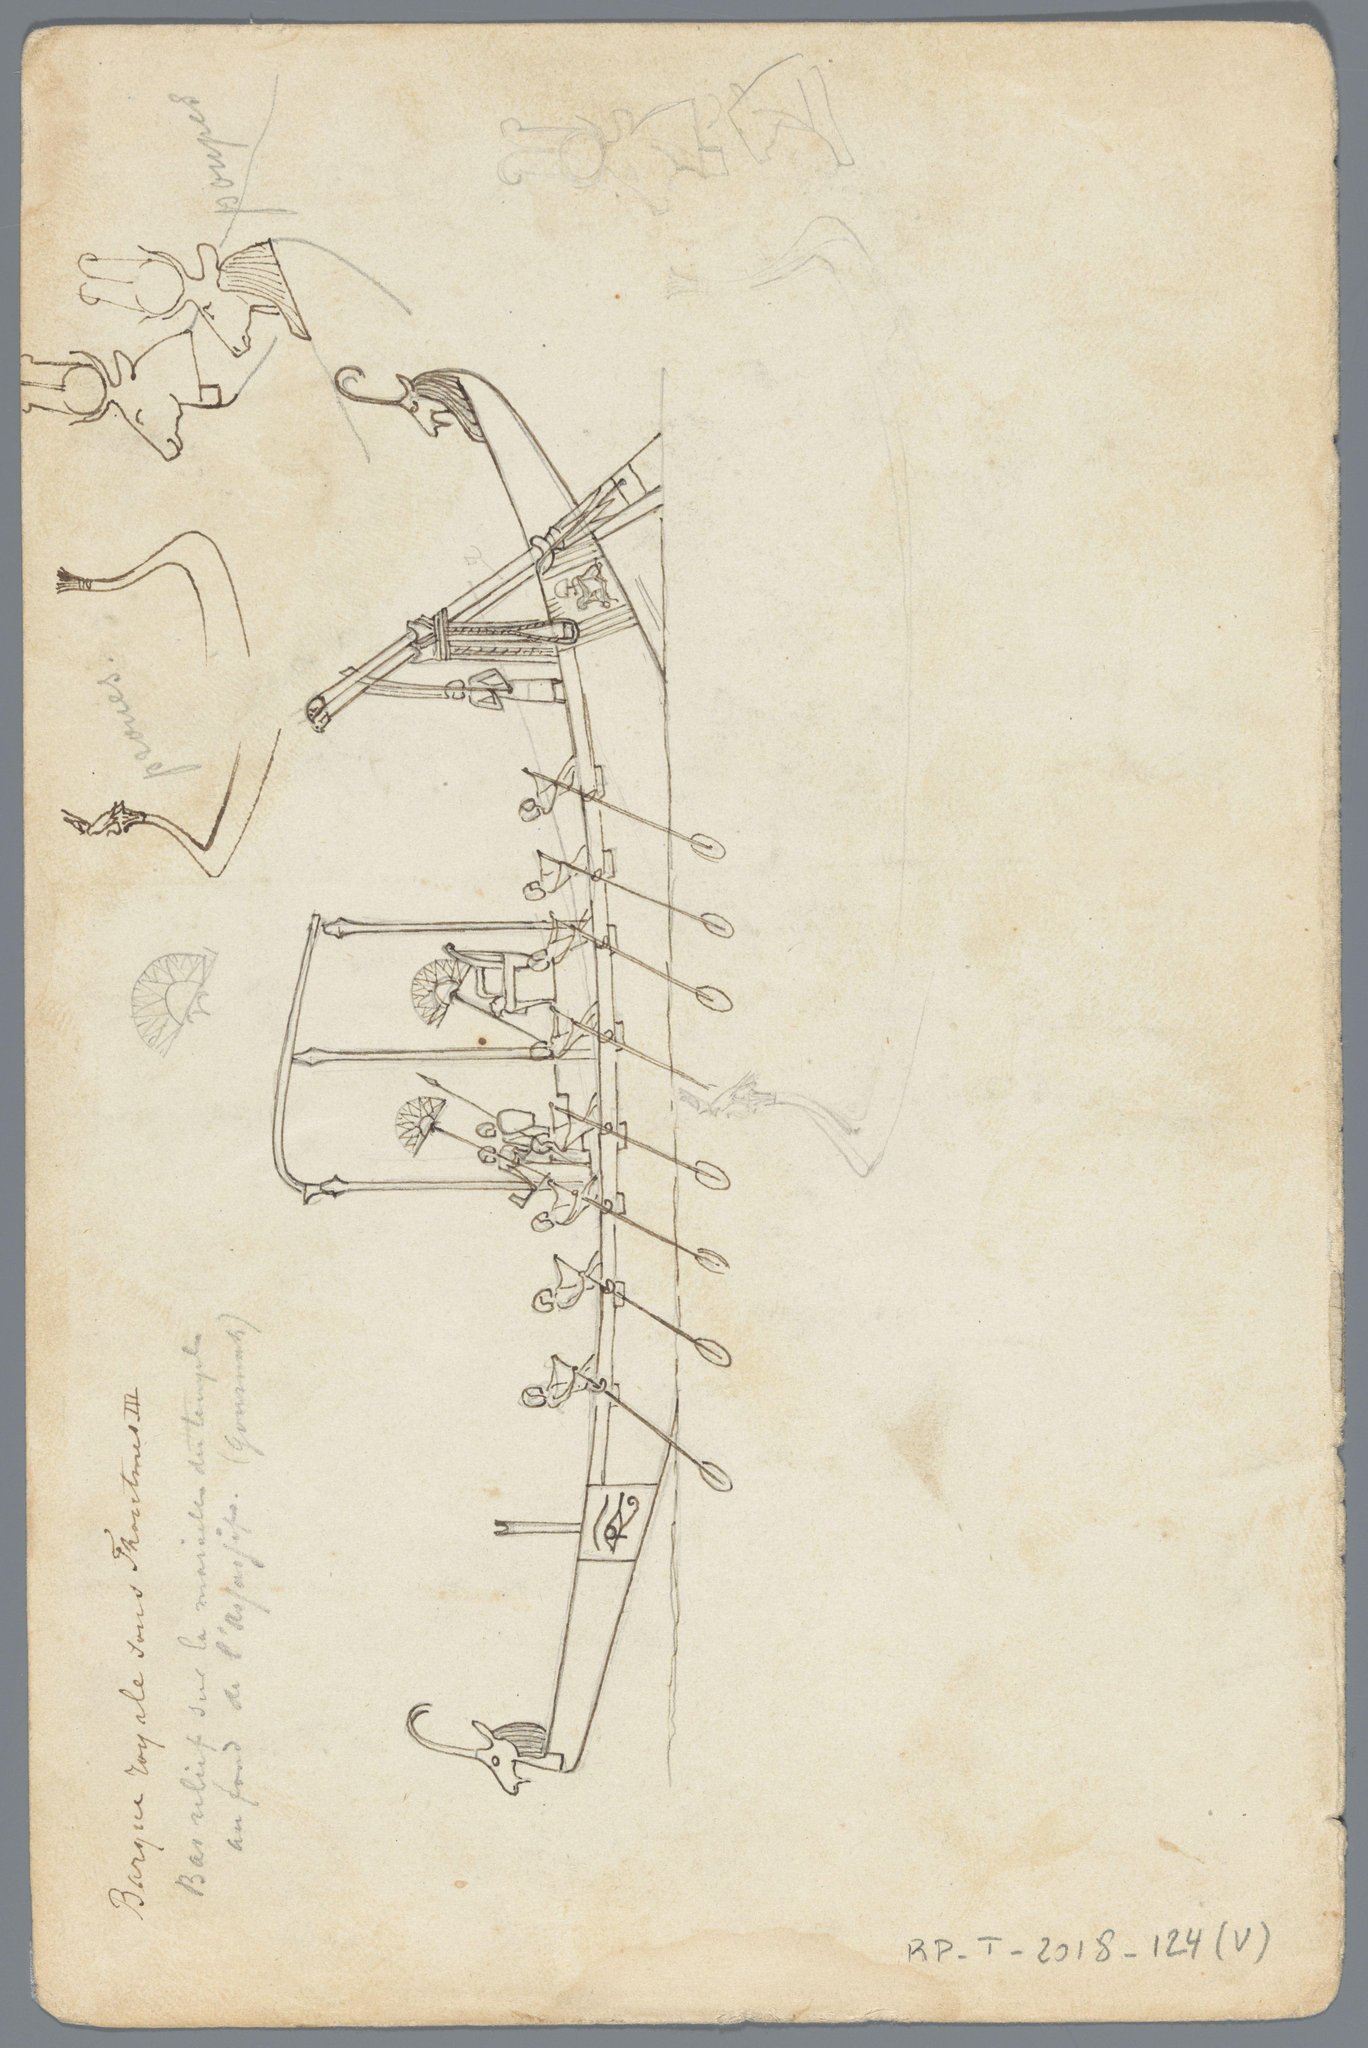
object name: sketchbook leaf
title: Natekening van een koninklijk schip op een basreliëf; met twee details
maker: willem de famars testas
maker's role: draughtsman, painter, print maker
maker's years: 1834-1896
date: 1858-1859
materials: ink, pencil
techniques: pen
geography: egypt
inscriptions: inscription: ‘poupes’, inscription: ‘Baque royale sous Thoutmes III / Bas relief sur la muraille du temple / au fond de l’ assassif. (Gournah)’, inscription: ‘proues’